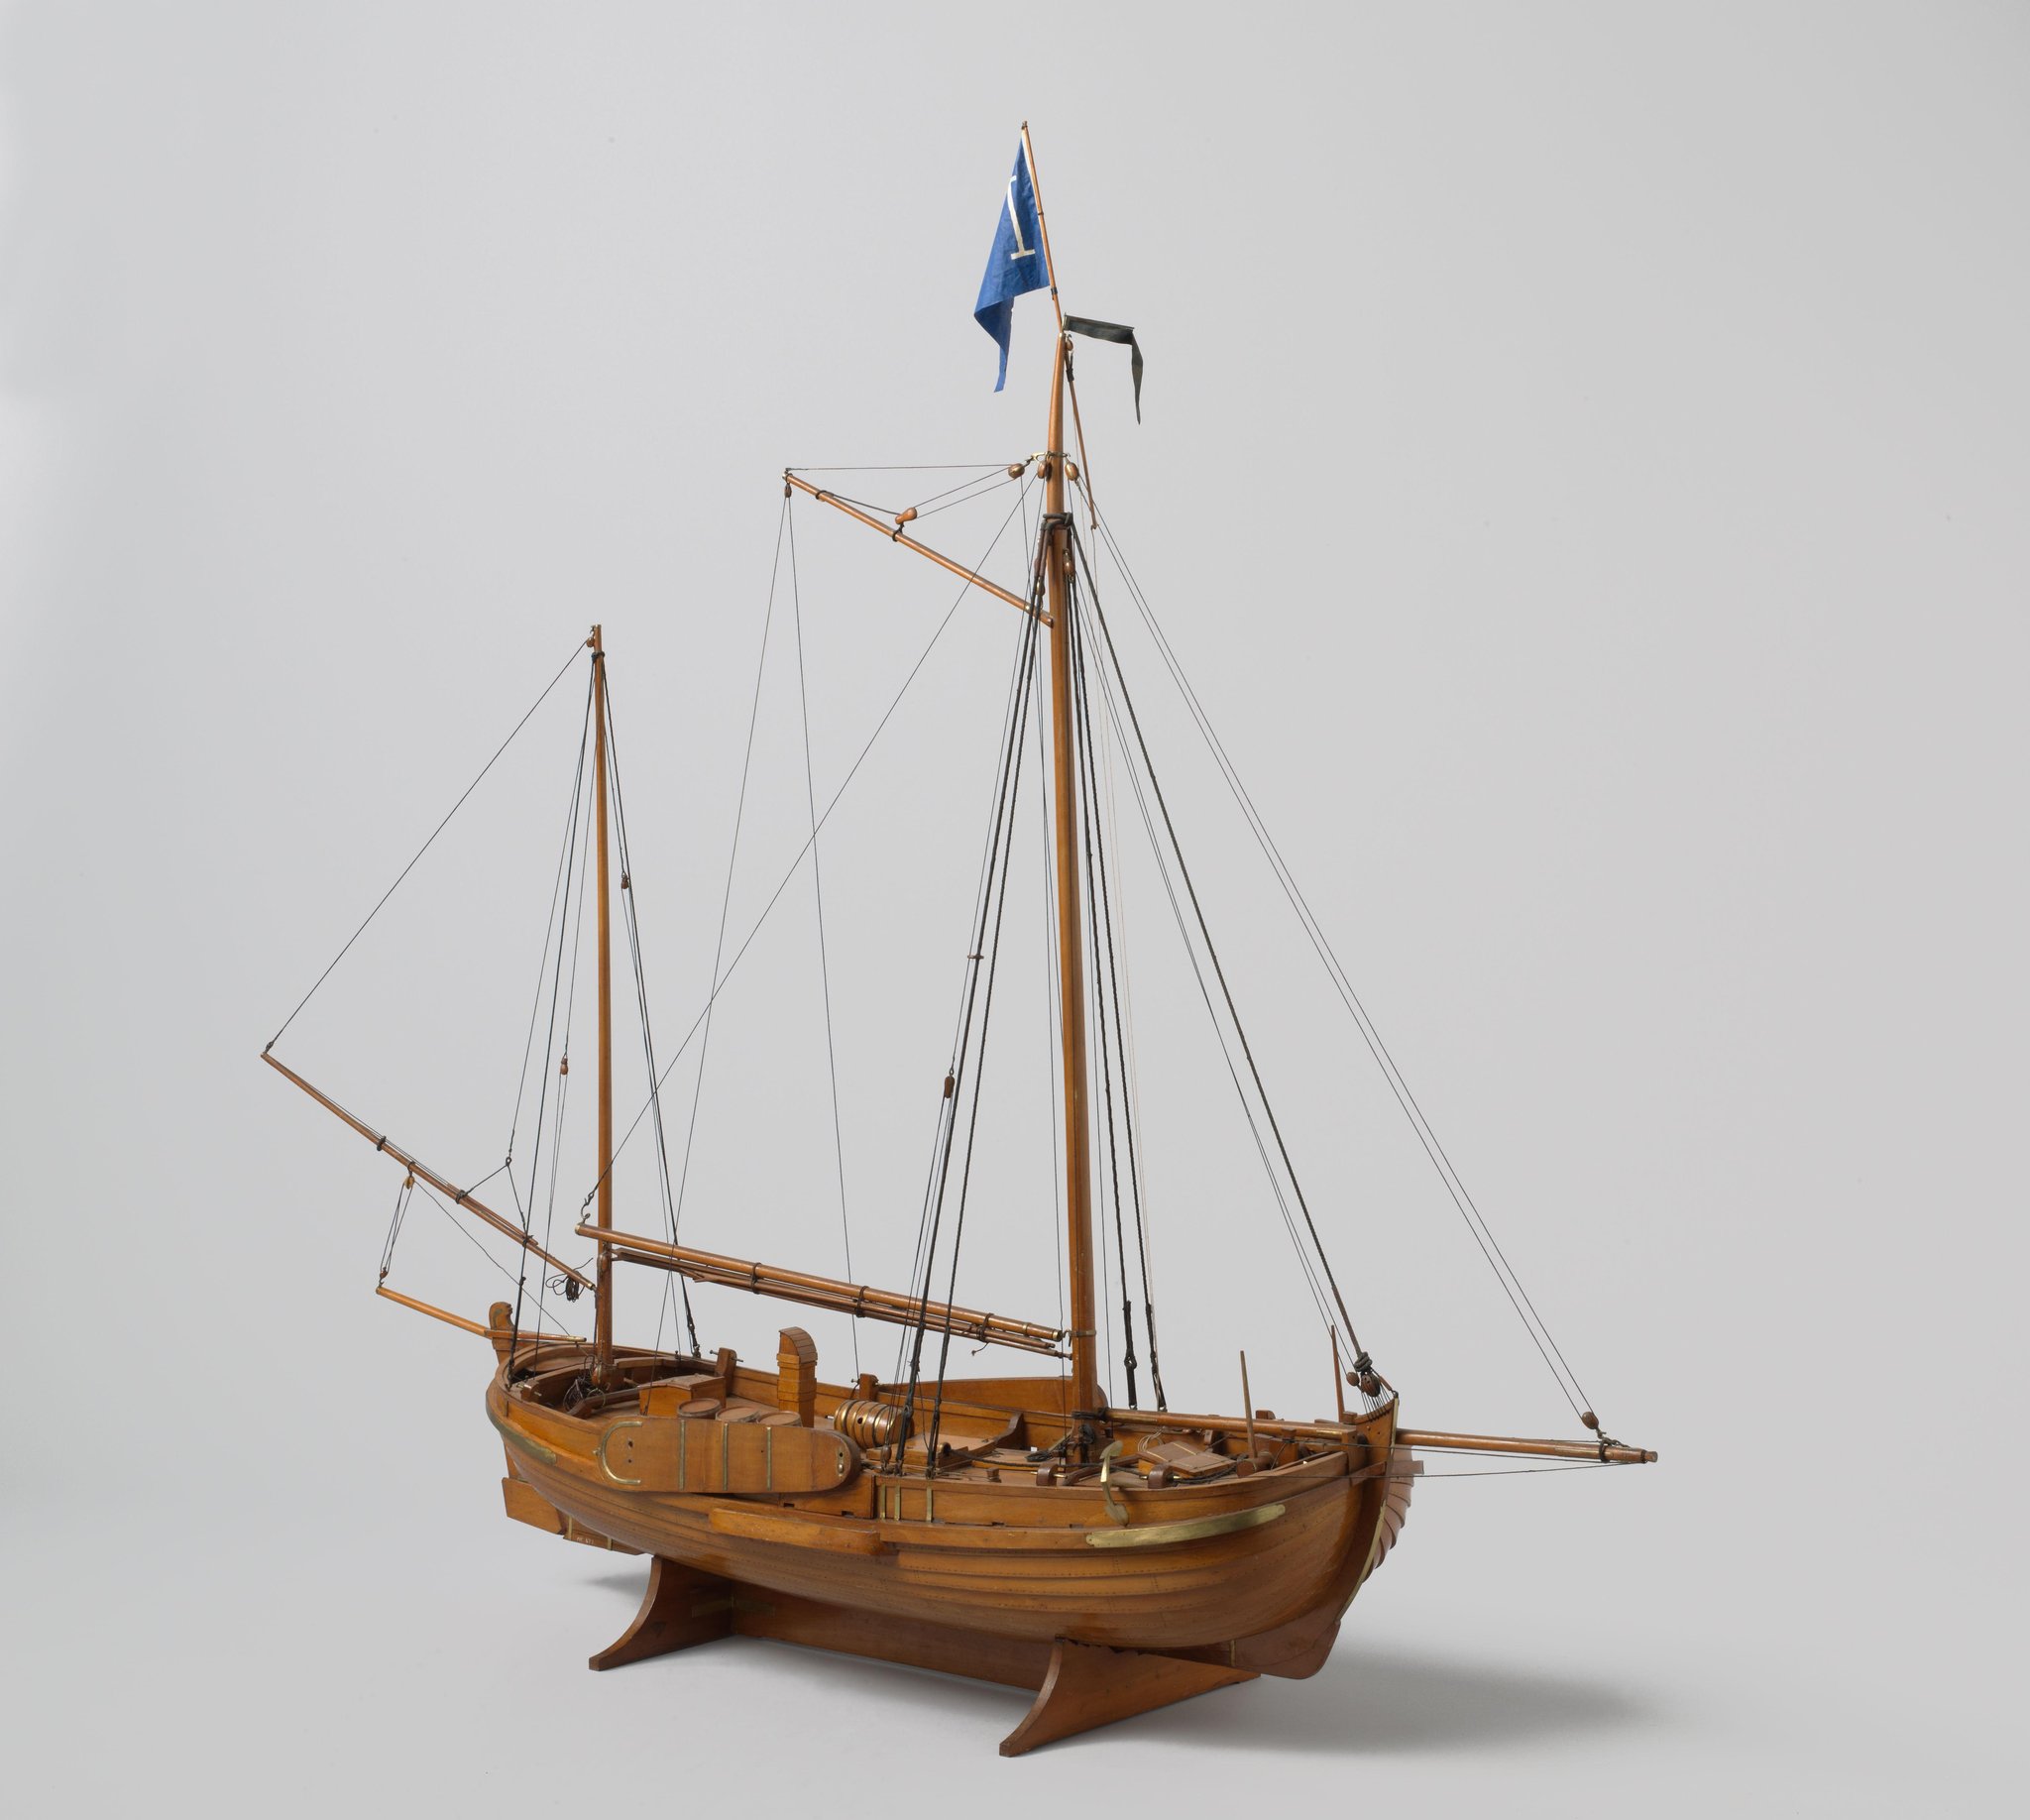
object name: ship model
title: Model of a Pilot Vessel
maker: cornelis over de linden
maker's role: model maker, ship modeller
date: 1836-1837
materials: brass, fiber, textile, wood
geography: willemsoord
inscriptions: inscription, on the flag: ‘Nº 1’, inscription, on various parts, in pencil: ‘Cornelis Over de Linden, Willemsoord, 1836-1837’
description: Getuigd uitgehold blokmodel van een tweemast platbodem. Delen van het dek kunnen afgenomen worden om de beschieting benedendeks te laten zien. Ronde boeg en achterschip, sterk vallende achtersteven; breed roer met zogklampen, versierde roerkop en houten helmstok. De zeeg loopt op naar beide uiteinden, een barkhout, twee zwaarden. Het model is voorzien van twee ankers, een braadspil, vier watervaten, een schoorsteen voor de kombuis, twee roeiriemen, twee pompen, twee opgangen en een grootluik. Het tuig is een anderhalvemast gaffeltuig zonder zeilen, met boegspriet en papegaaistok. Schaal 1:20 (volgens Obreen).